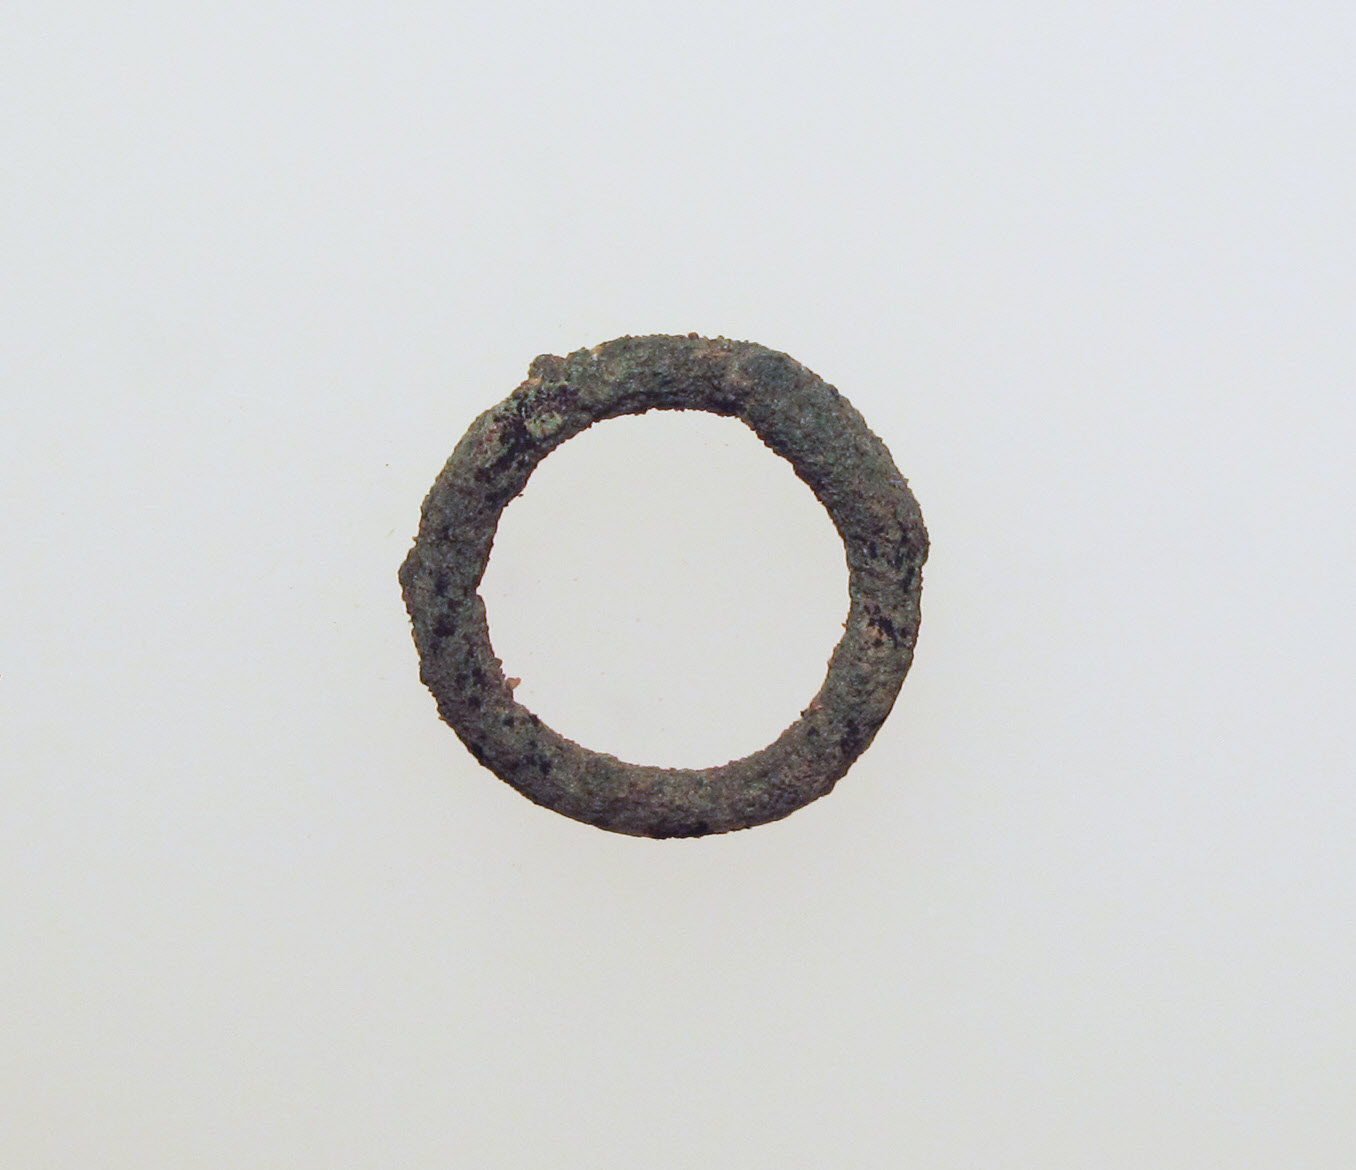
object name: earring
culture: cypriot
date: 3900 BCE-100 CE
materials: bronze, gold